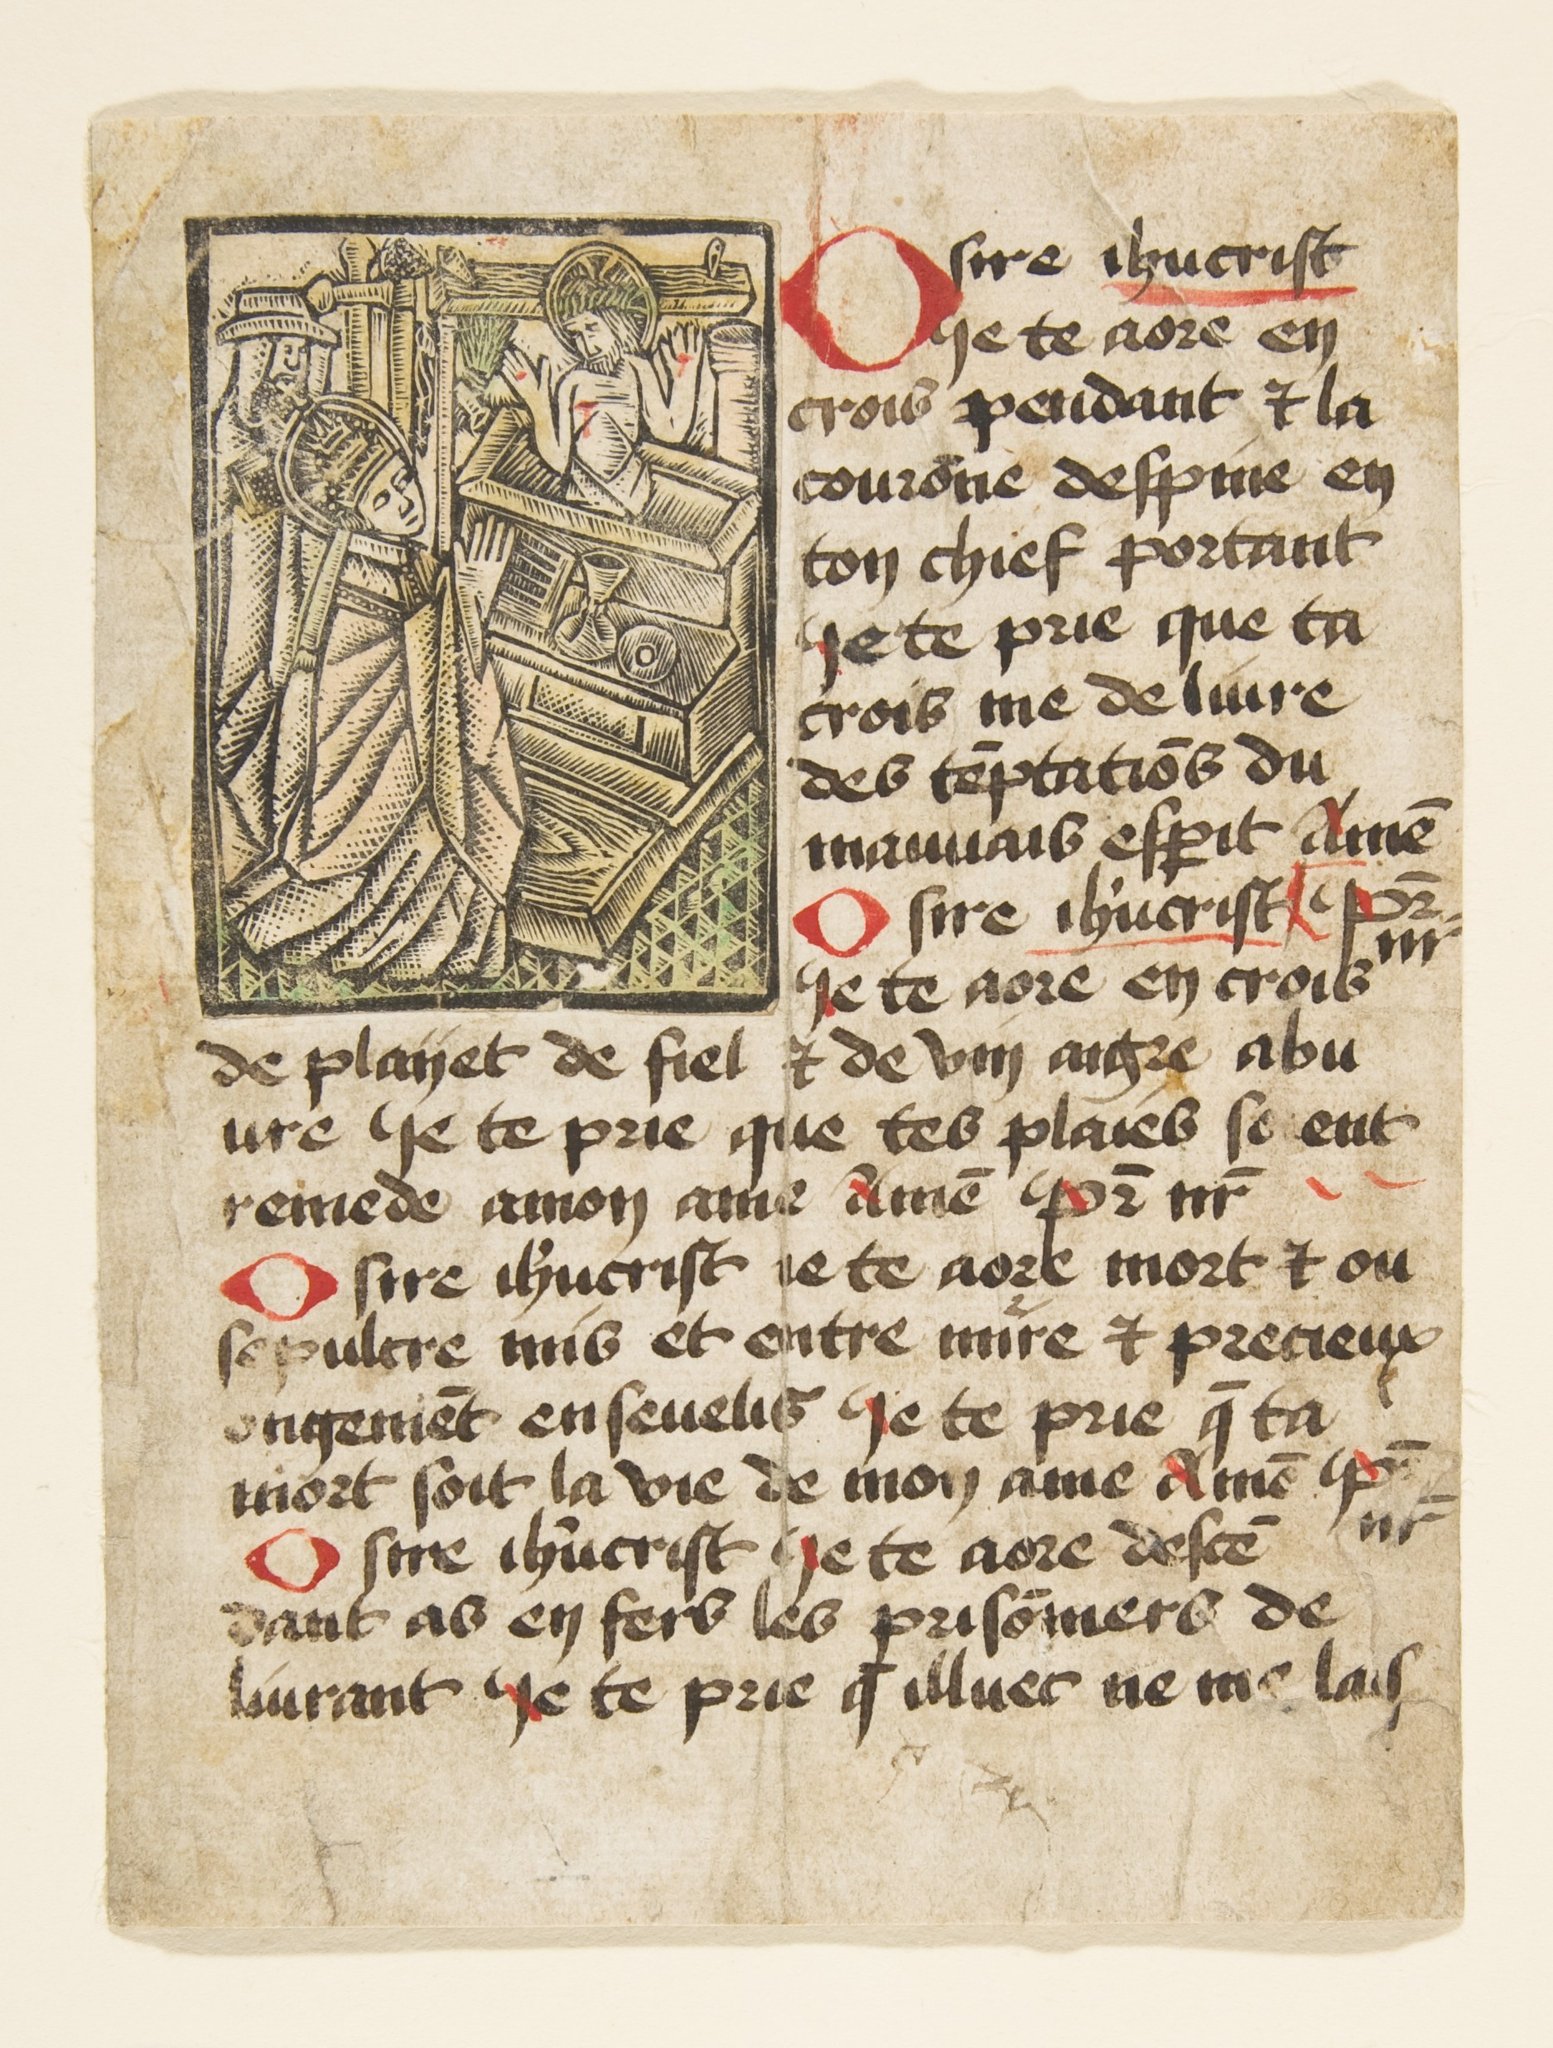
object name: print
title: Mass of St. Gregory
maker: anonymous, german, 15th century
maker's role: artist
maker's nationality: german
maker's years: 1400-1500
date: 1401-1500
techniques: hand coloring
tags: popes,jesus,saints